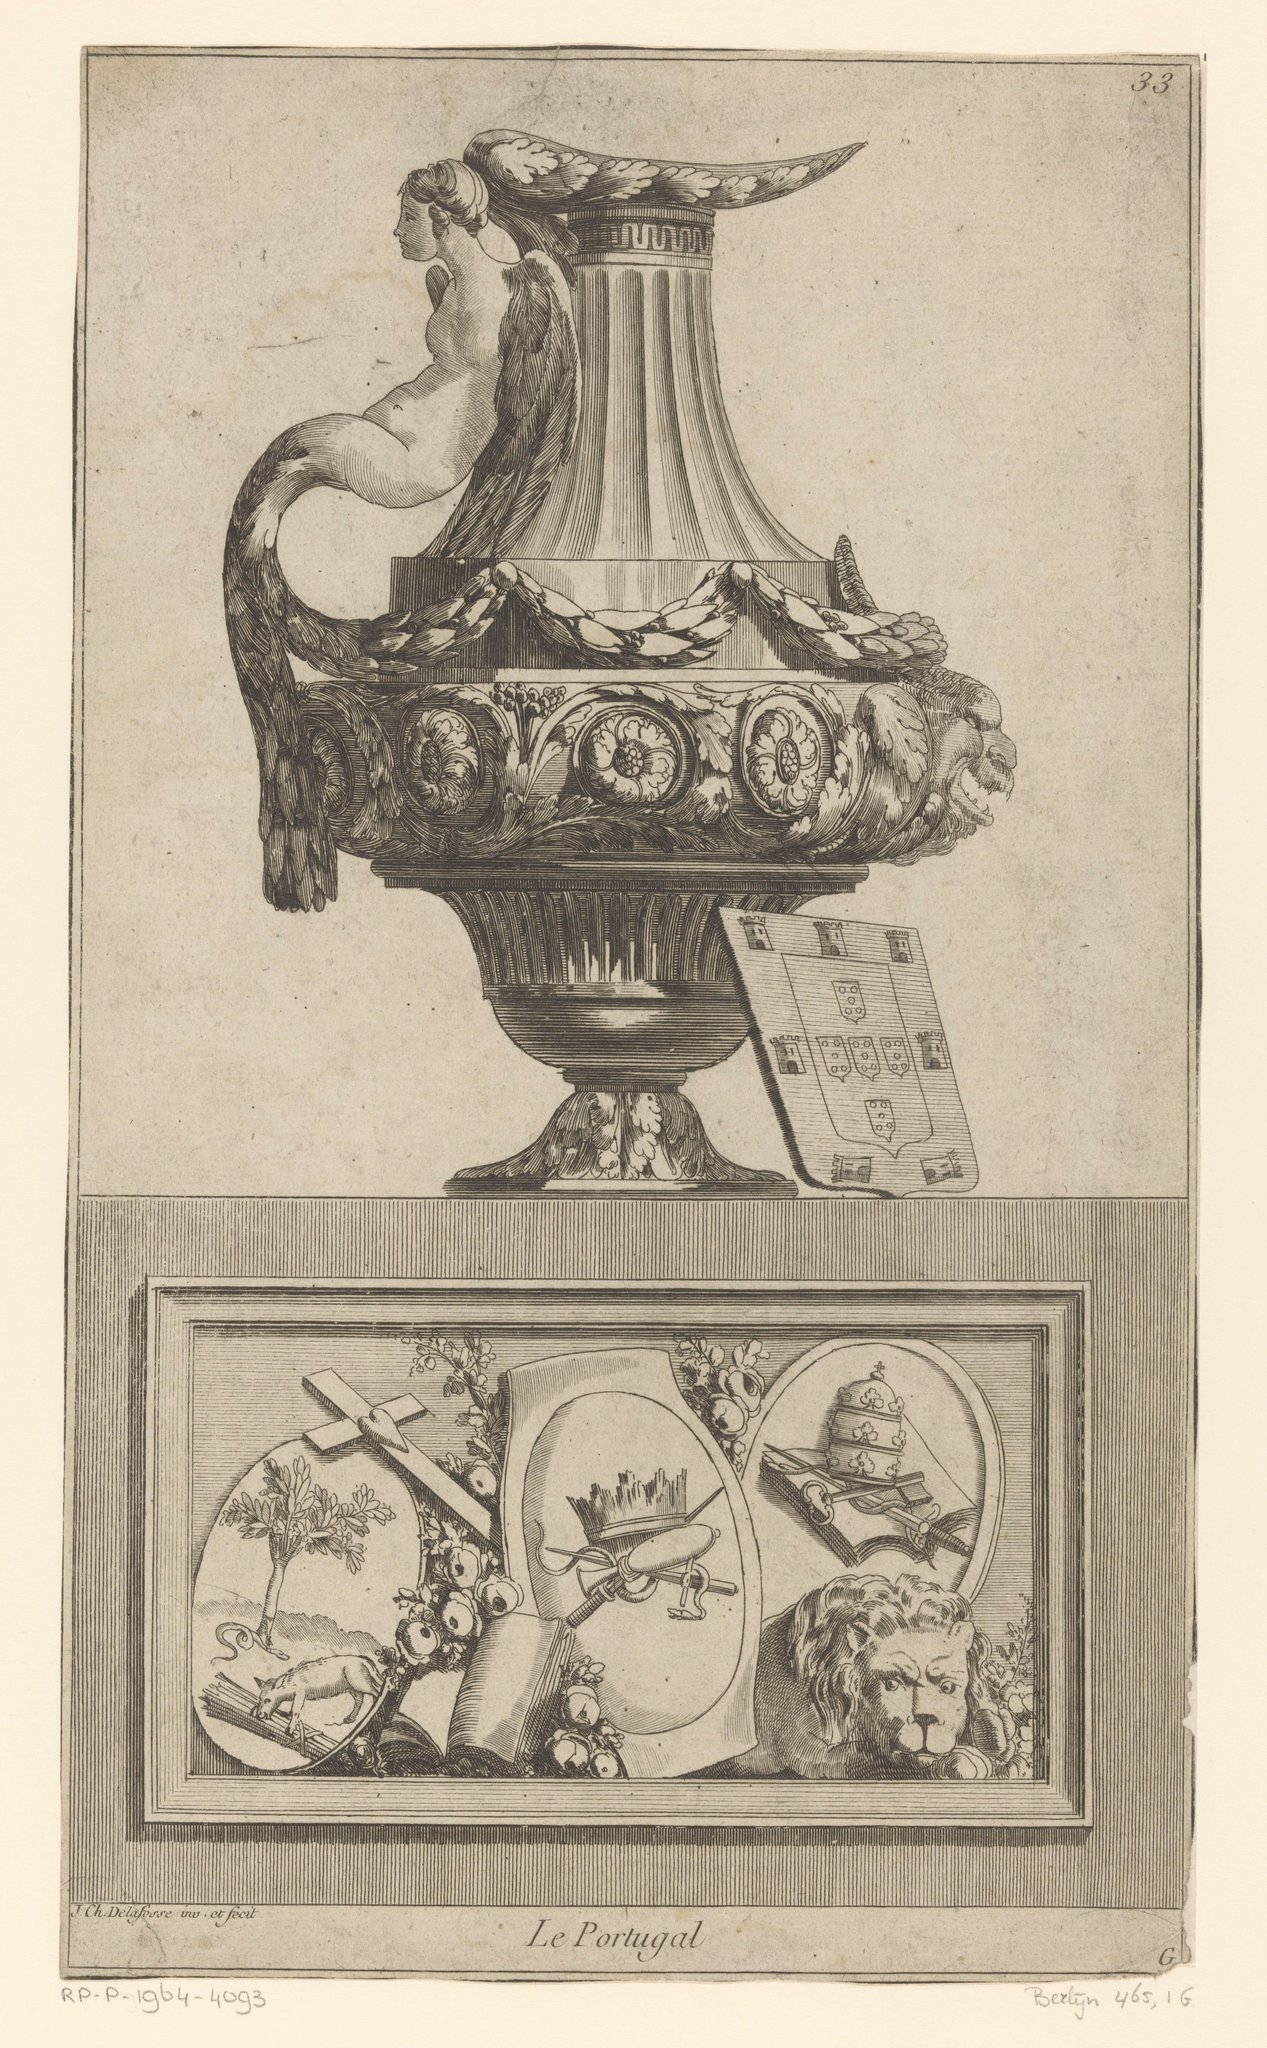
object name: ornament print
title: G Vases en travers, cartouche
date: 1768-1771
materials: paper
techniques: engraving, etching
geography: paris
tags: vase ~ ornament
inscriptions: collector's mark: Lugt 2760, collector's mark: Lugt 2228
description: Een geornamenteerde vaas met bloemmotieven en een vrouwelijke gevleugelde halffiguur. Daaronder een rechthoekige lijst met een leeuw en drie medaillons met de pauselijke tiara op een boek, een kroon en wapens en dieren bij een boom. Prentnummer 33.